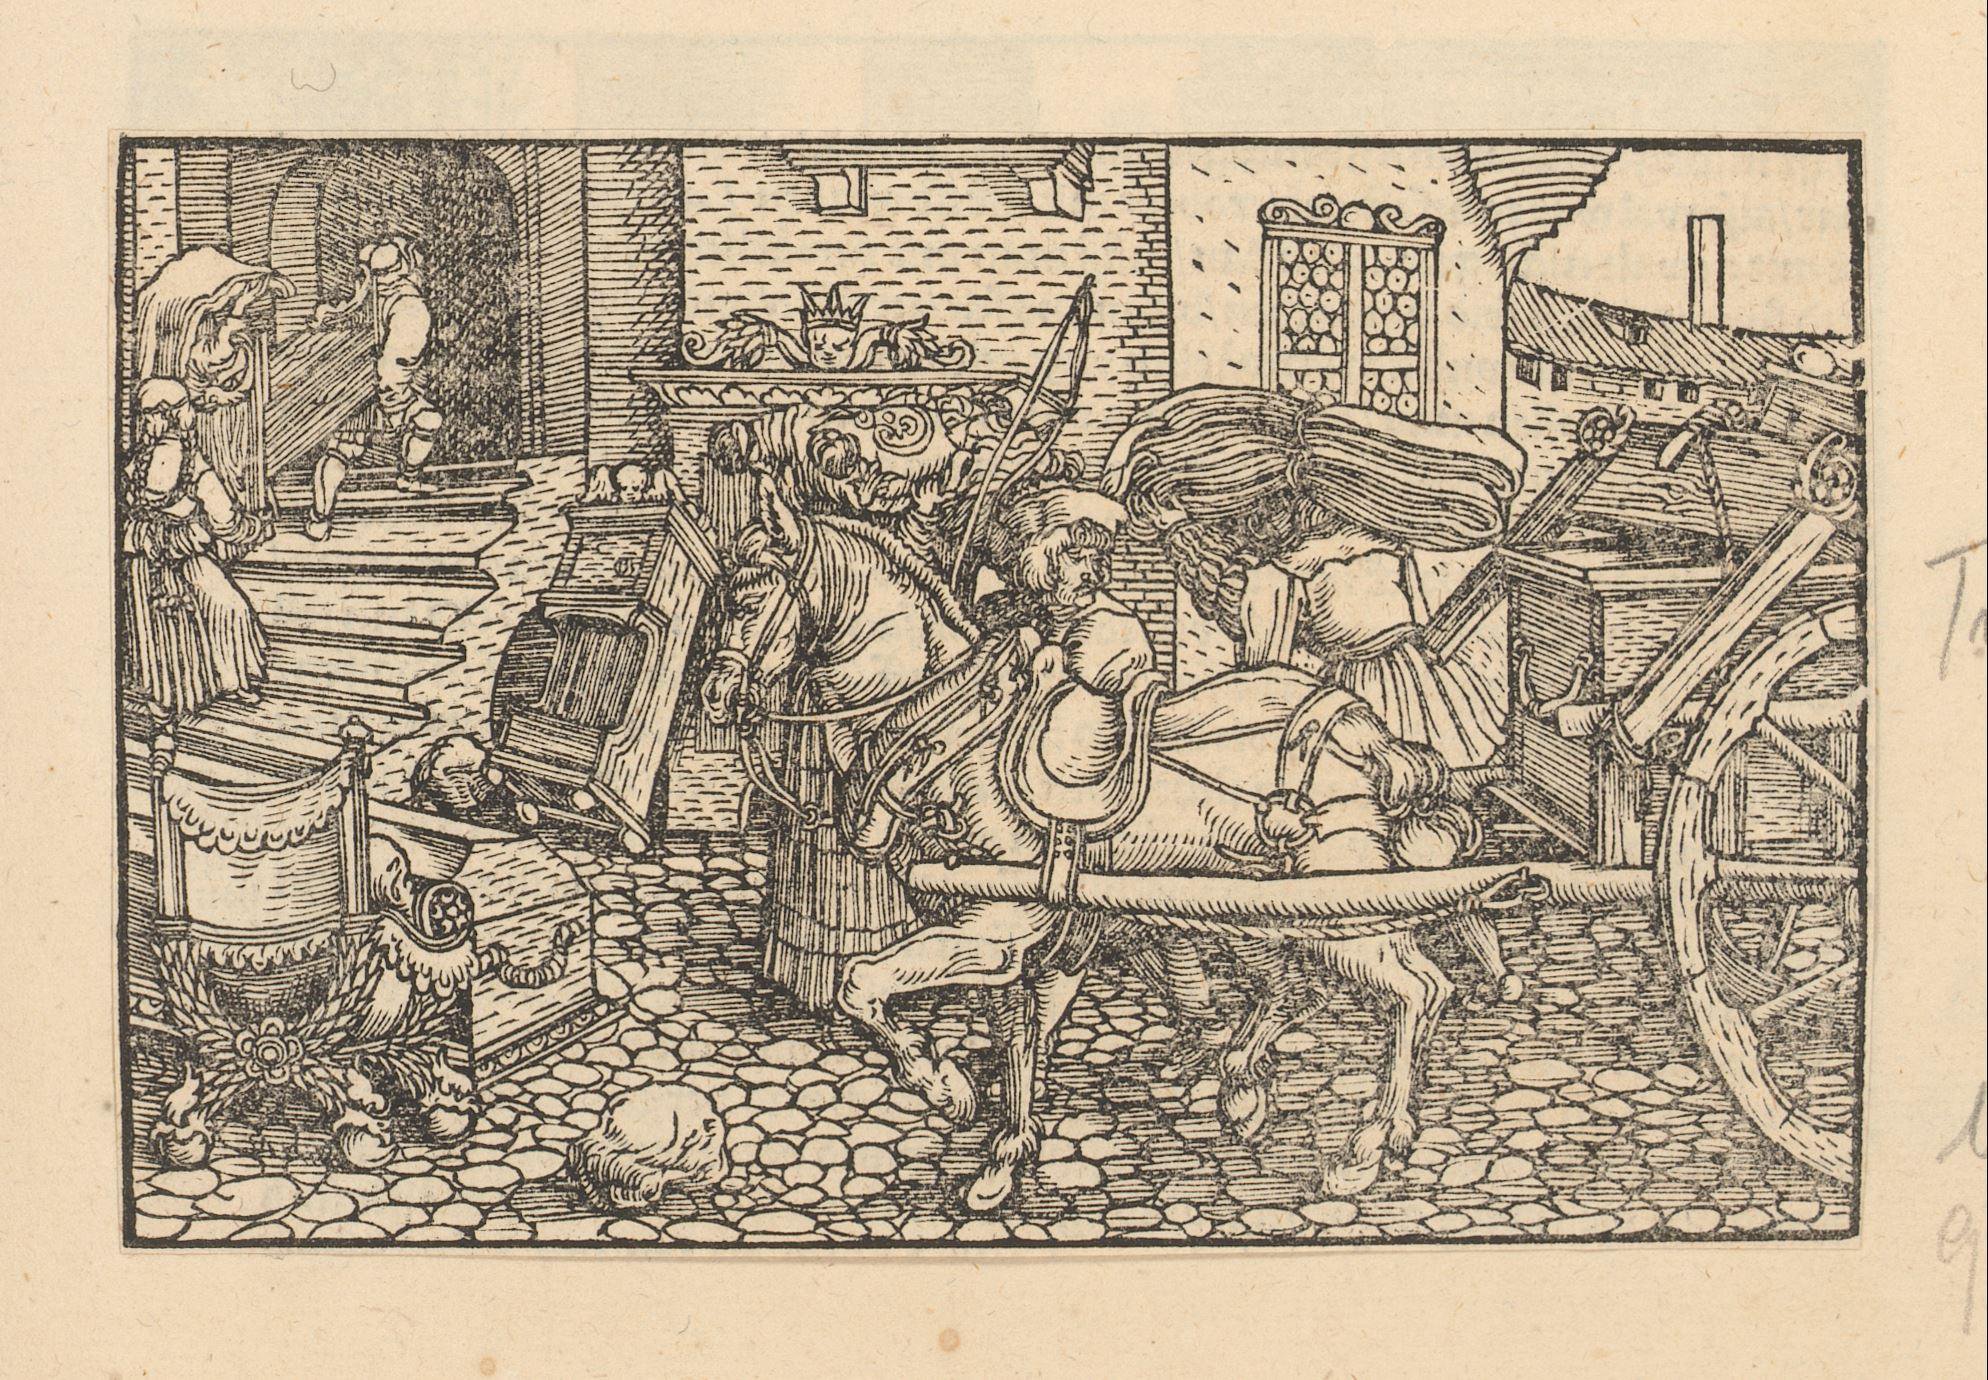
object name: book illustration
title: Uitladen van het huisraad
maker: Anonymous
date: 1514-1532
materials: paper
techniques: letterpress printing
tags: moving (house), carrying something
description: Deze prent is gebruikt in: Petrarca, Francesco. Von der Artzney bayder Glück, des guten und widerwertigen: unnd weß sich ain yeder inn Gelück und Unglück halten sol (...). Augsburg: Heinrich Steiner, 1532. Deze uitgave is ook bekend onder de titel 'Trostspiegel in Glück und Unglück'.